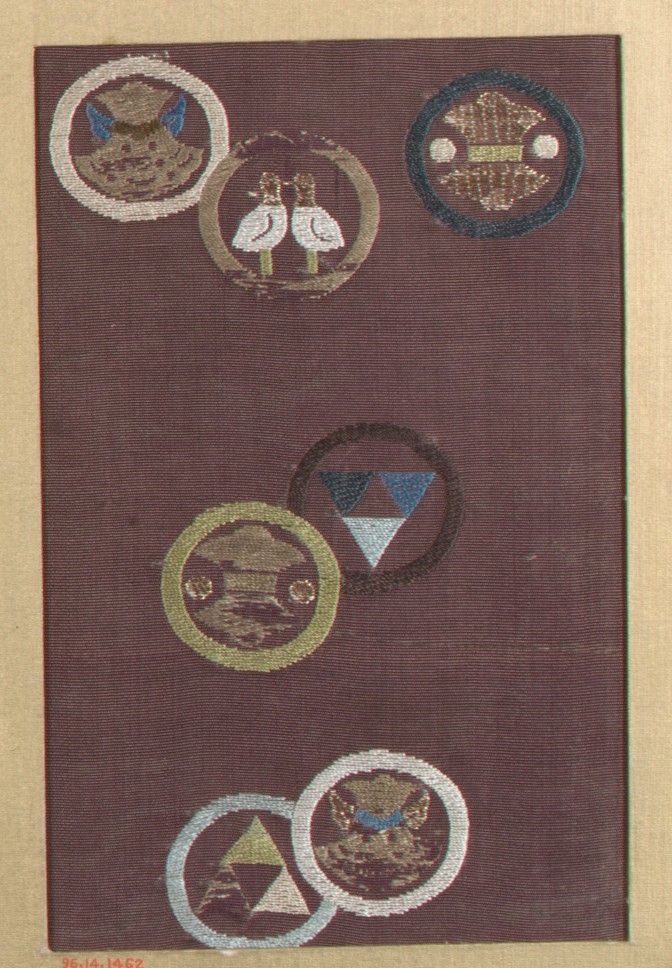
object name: piece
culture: japanese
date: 1701-1900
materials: silk